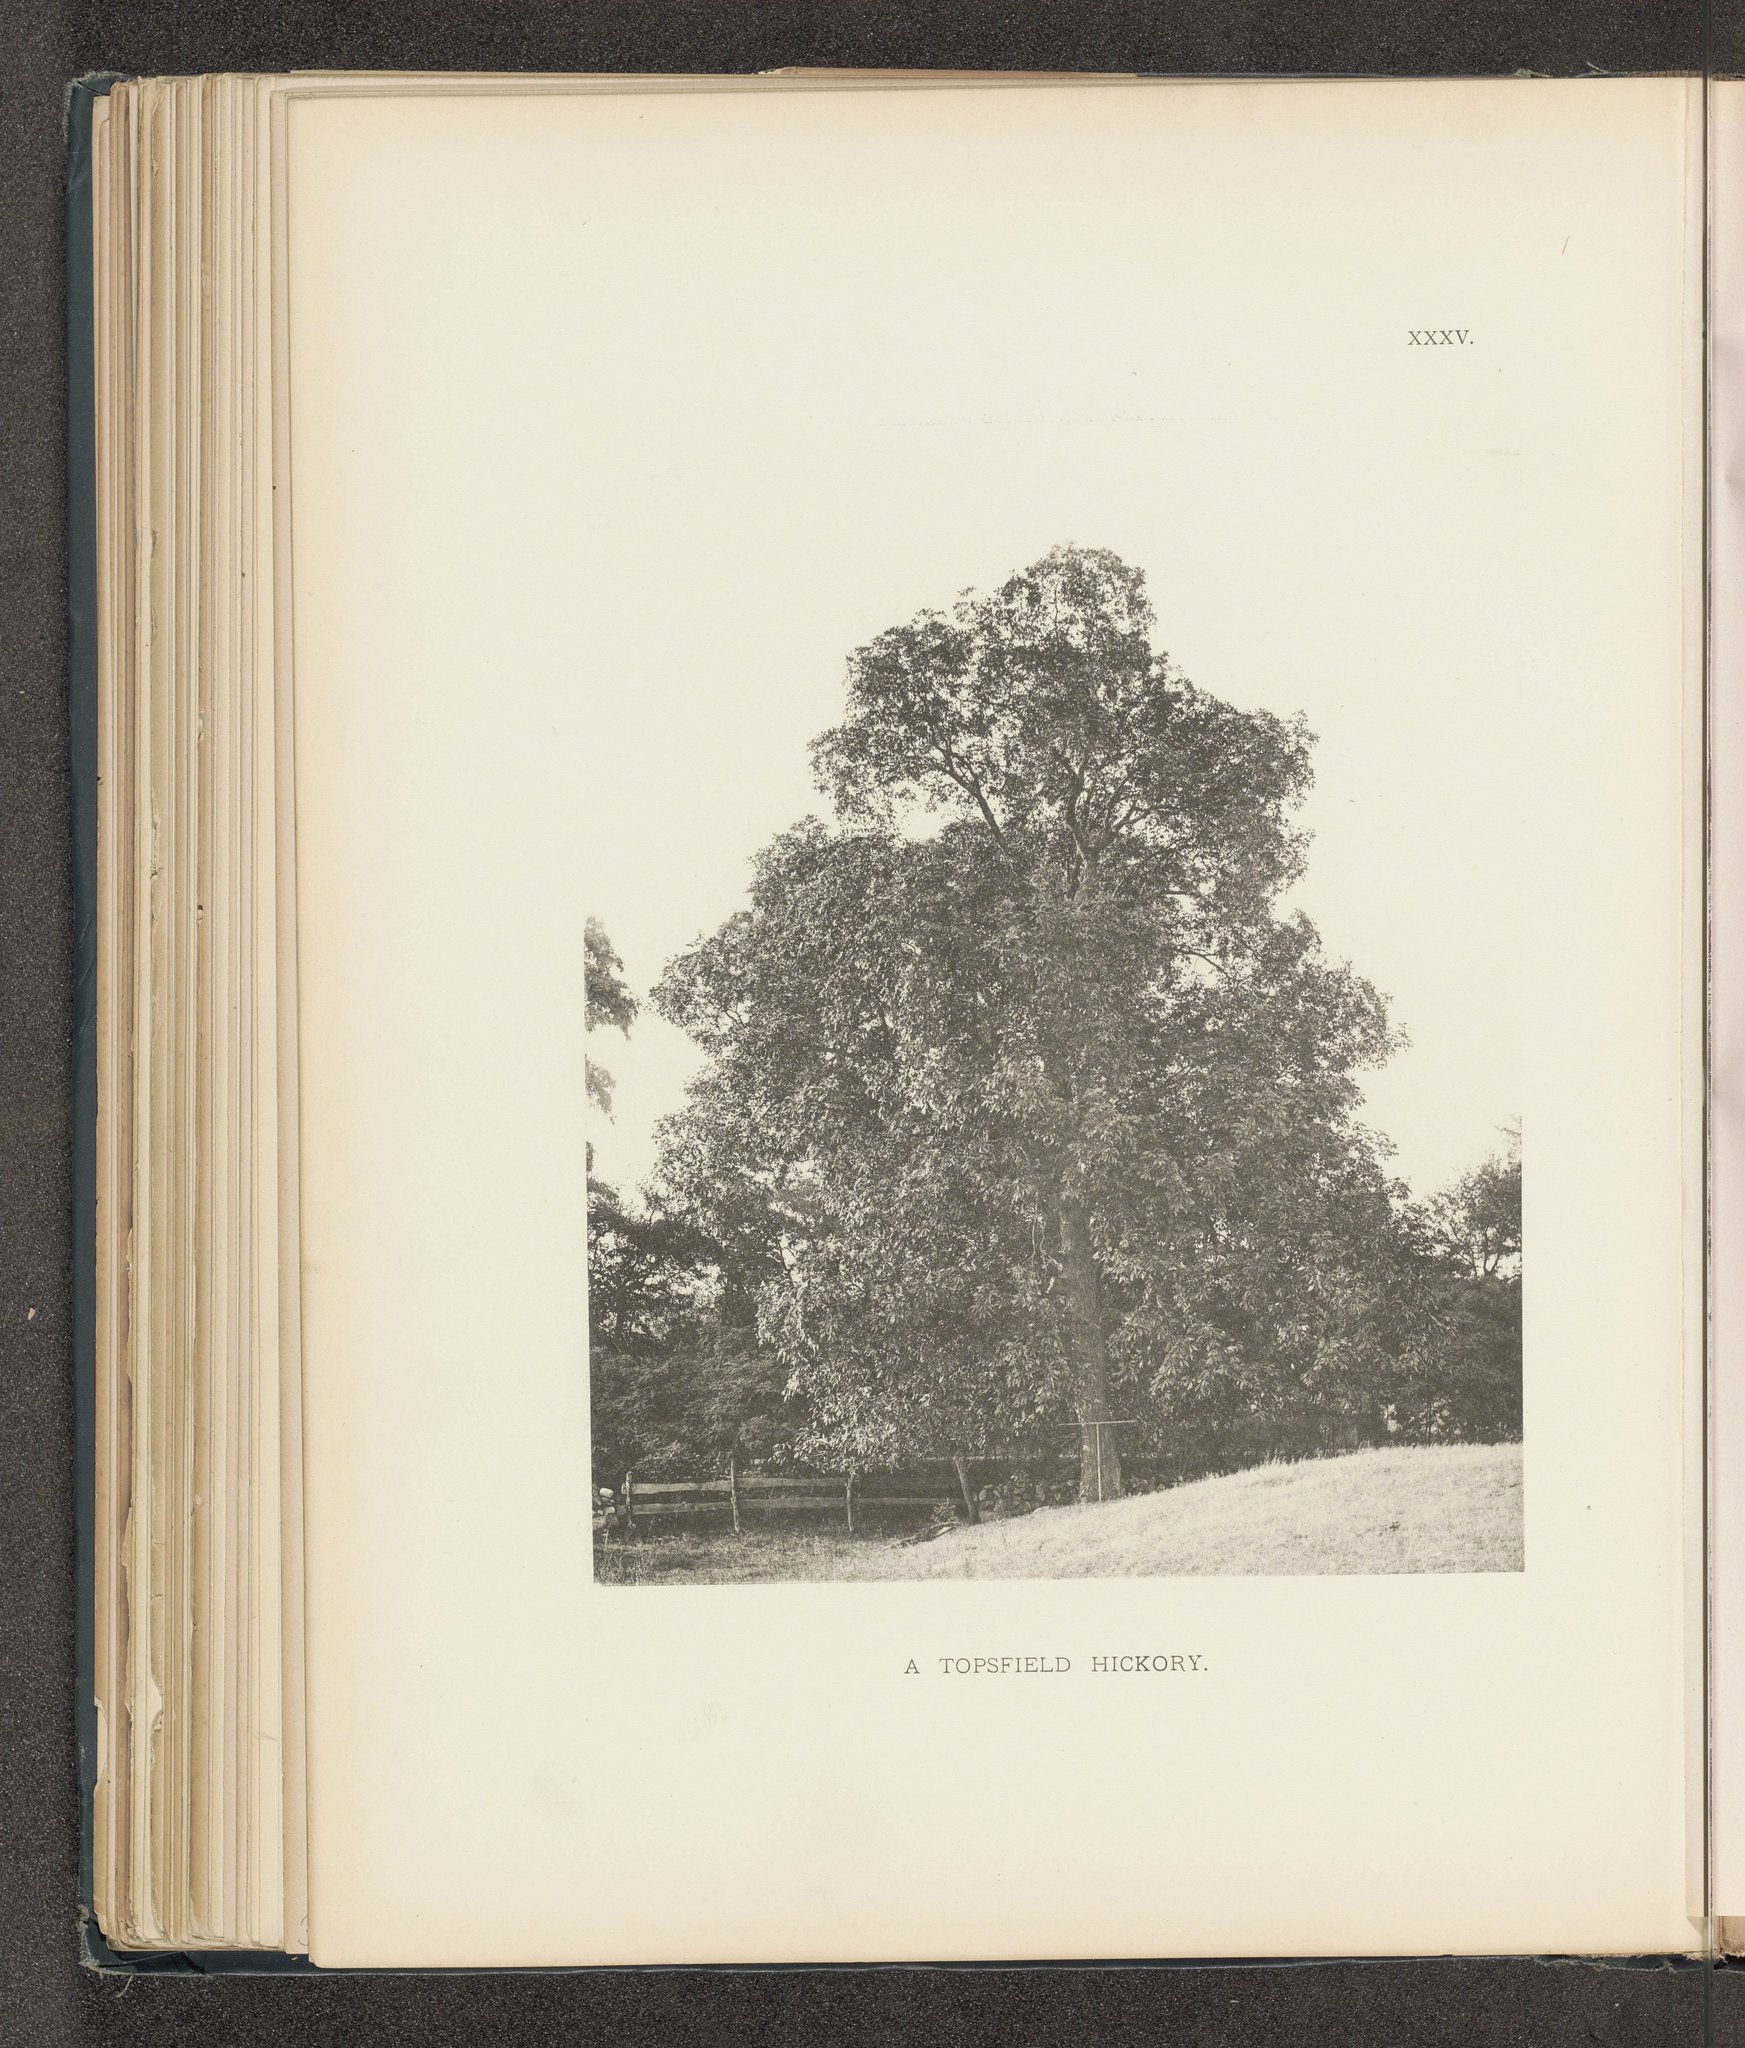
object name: photomechanical print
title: A Topsfield hickory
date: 1880-1890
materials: paper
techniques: photograph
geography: massachusetts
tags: trees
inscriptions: number: ‘XXXV.’